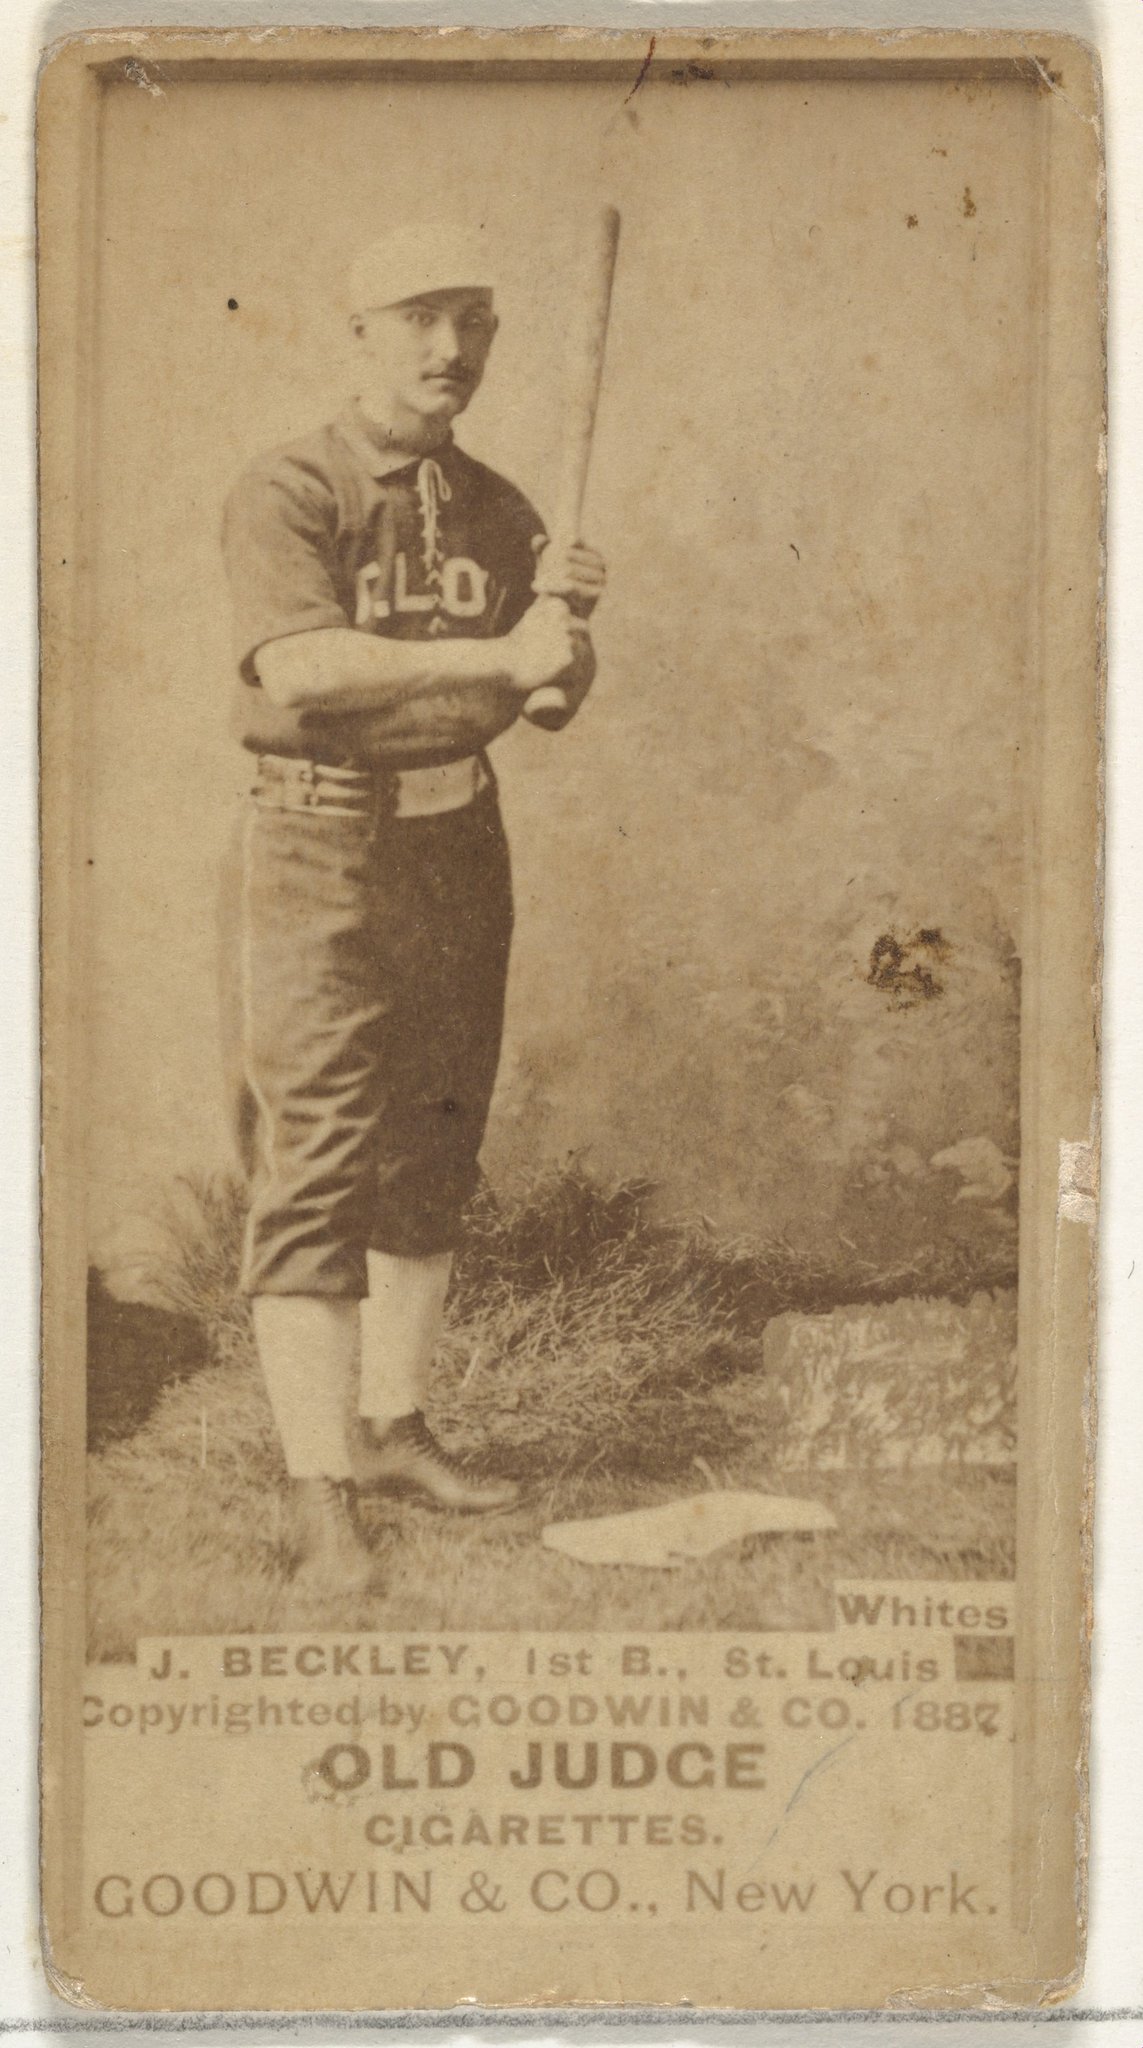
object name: baseball card, photograph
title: Beckley, 1st Base, St. Louis Whites, from the Old Judge series (N172) for Old Judge Cigarettes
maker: goodwin & company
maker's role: publisher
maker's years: 1850-1950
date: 1888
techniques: albumen silver print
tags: men,portraits,baseball,athletes